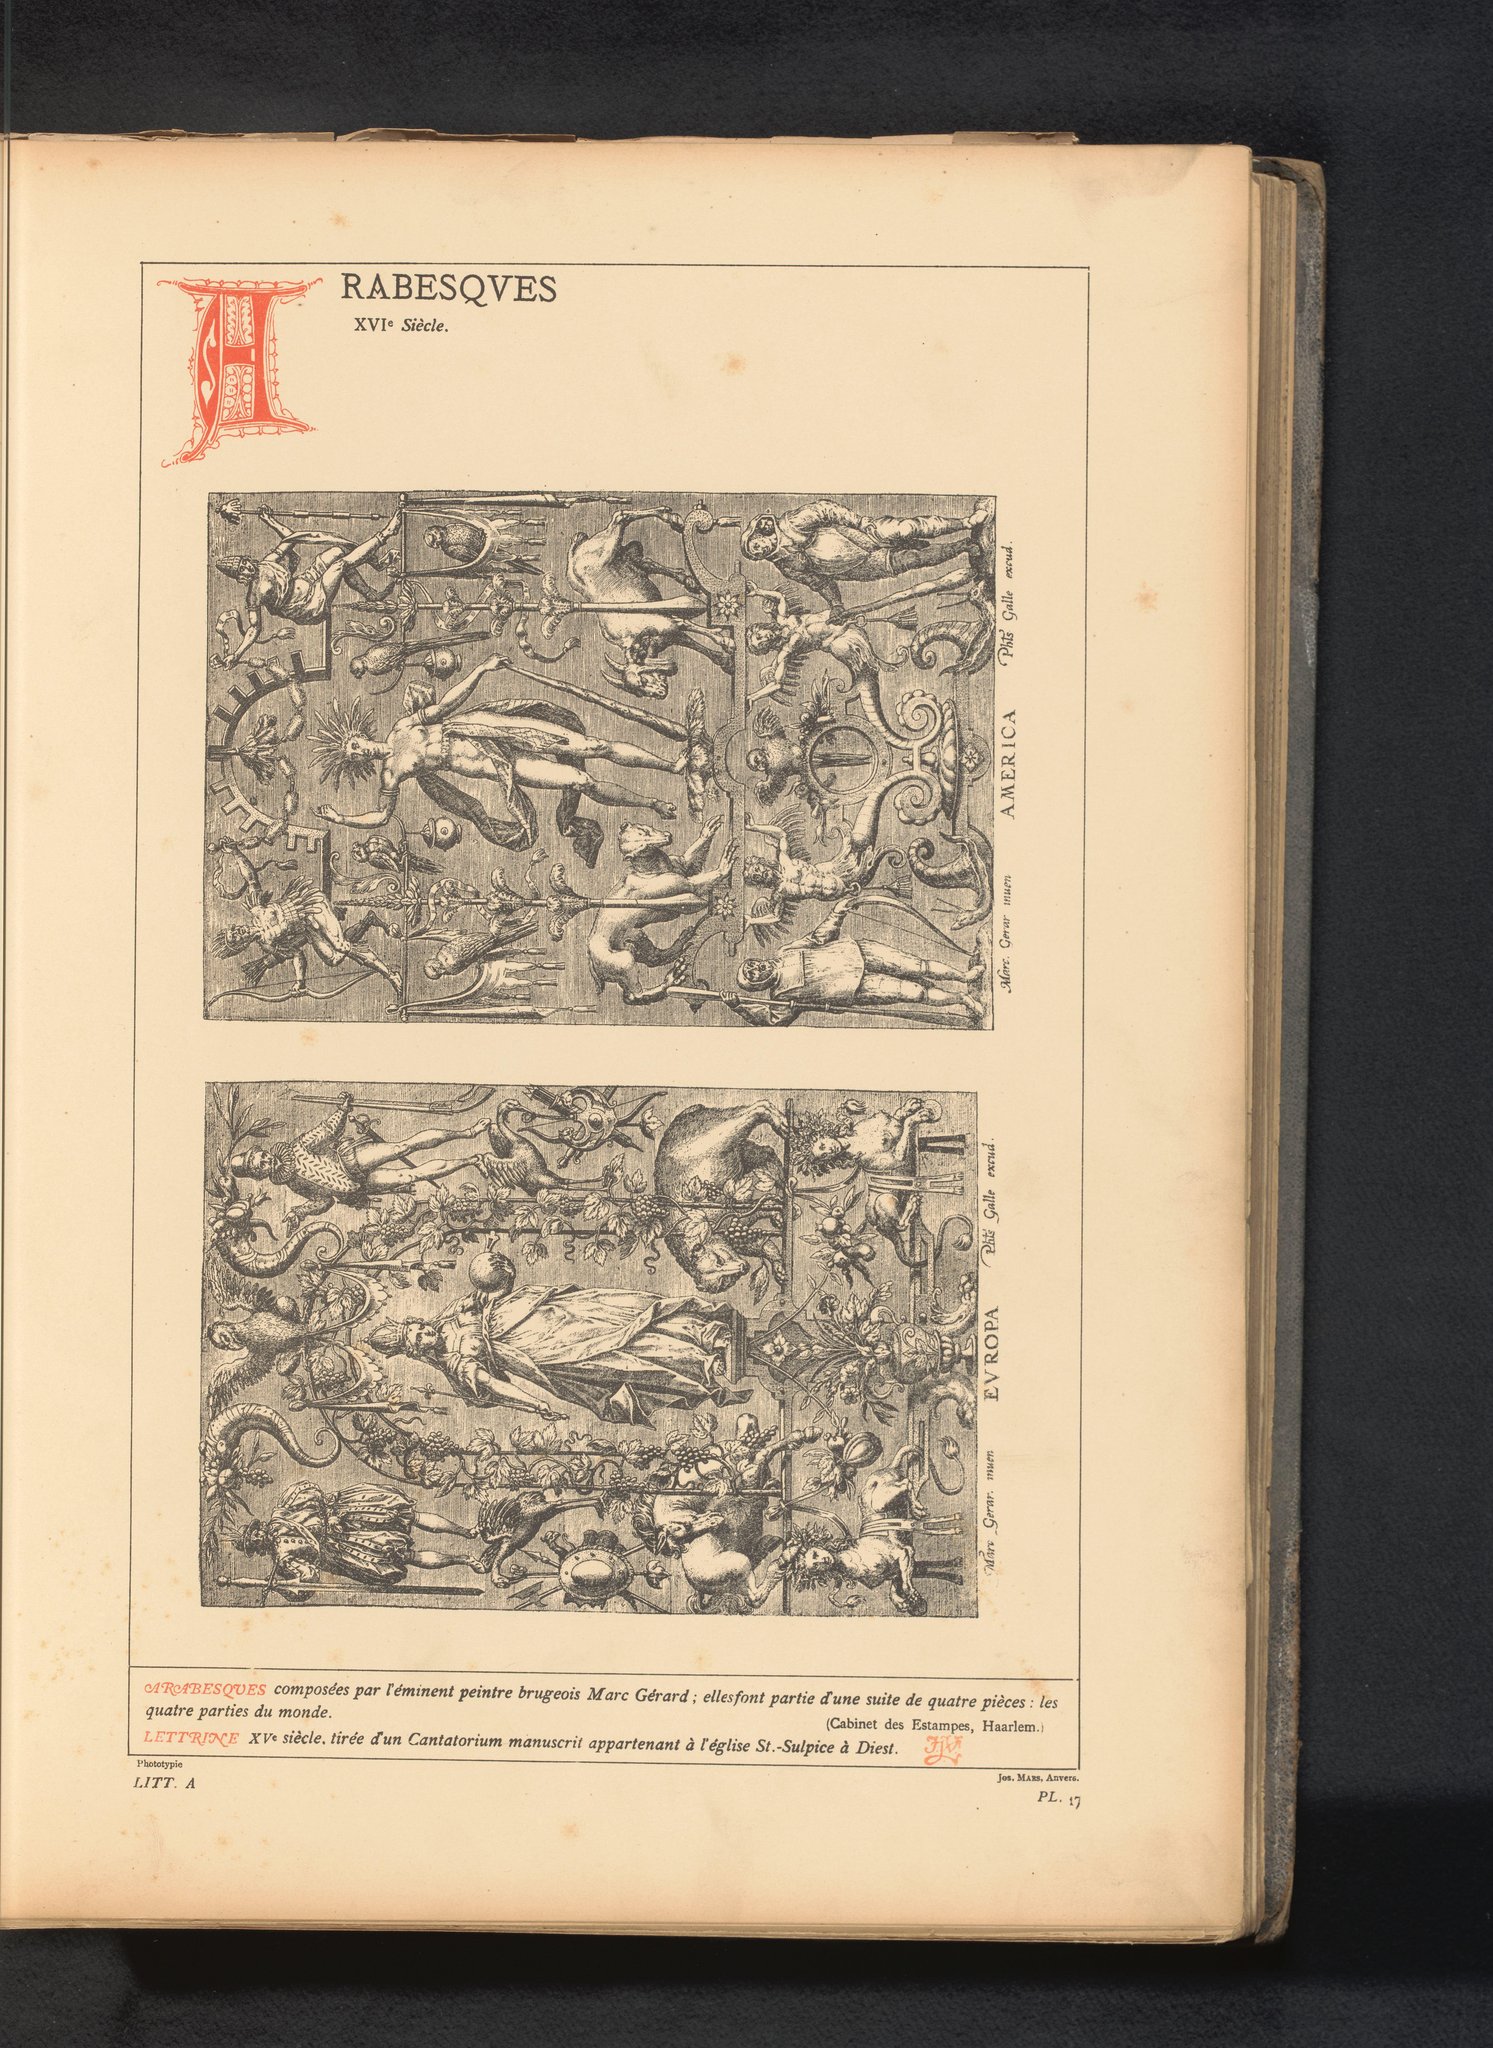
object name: reproduction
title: Reproductie van twee ontwerpen met allegorieën van Europa en Amerika door Marcus Gheeraerts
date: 1875-1880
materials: paper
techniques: photolithography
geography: antwerp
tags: europe represented allegorically; 'europa' (ripa), america represented allegorically; 'america' (ripa)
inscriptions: inscription: ‘LITT: A. - PL. 17’, inscription: ‘Arabesques composées par (...)’, monogram: ‘JJvY’